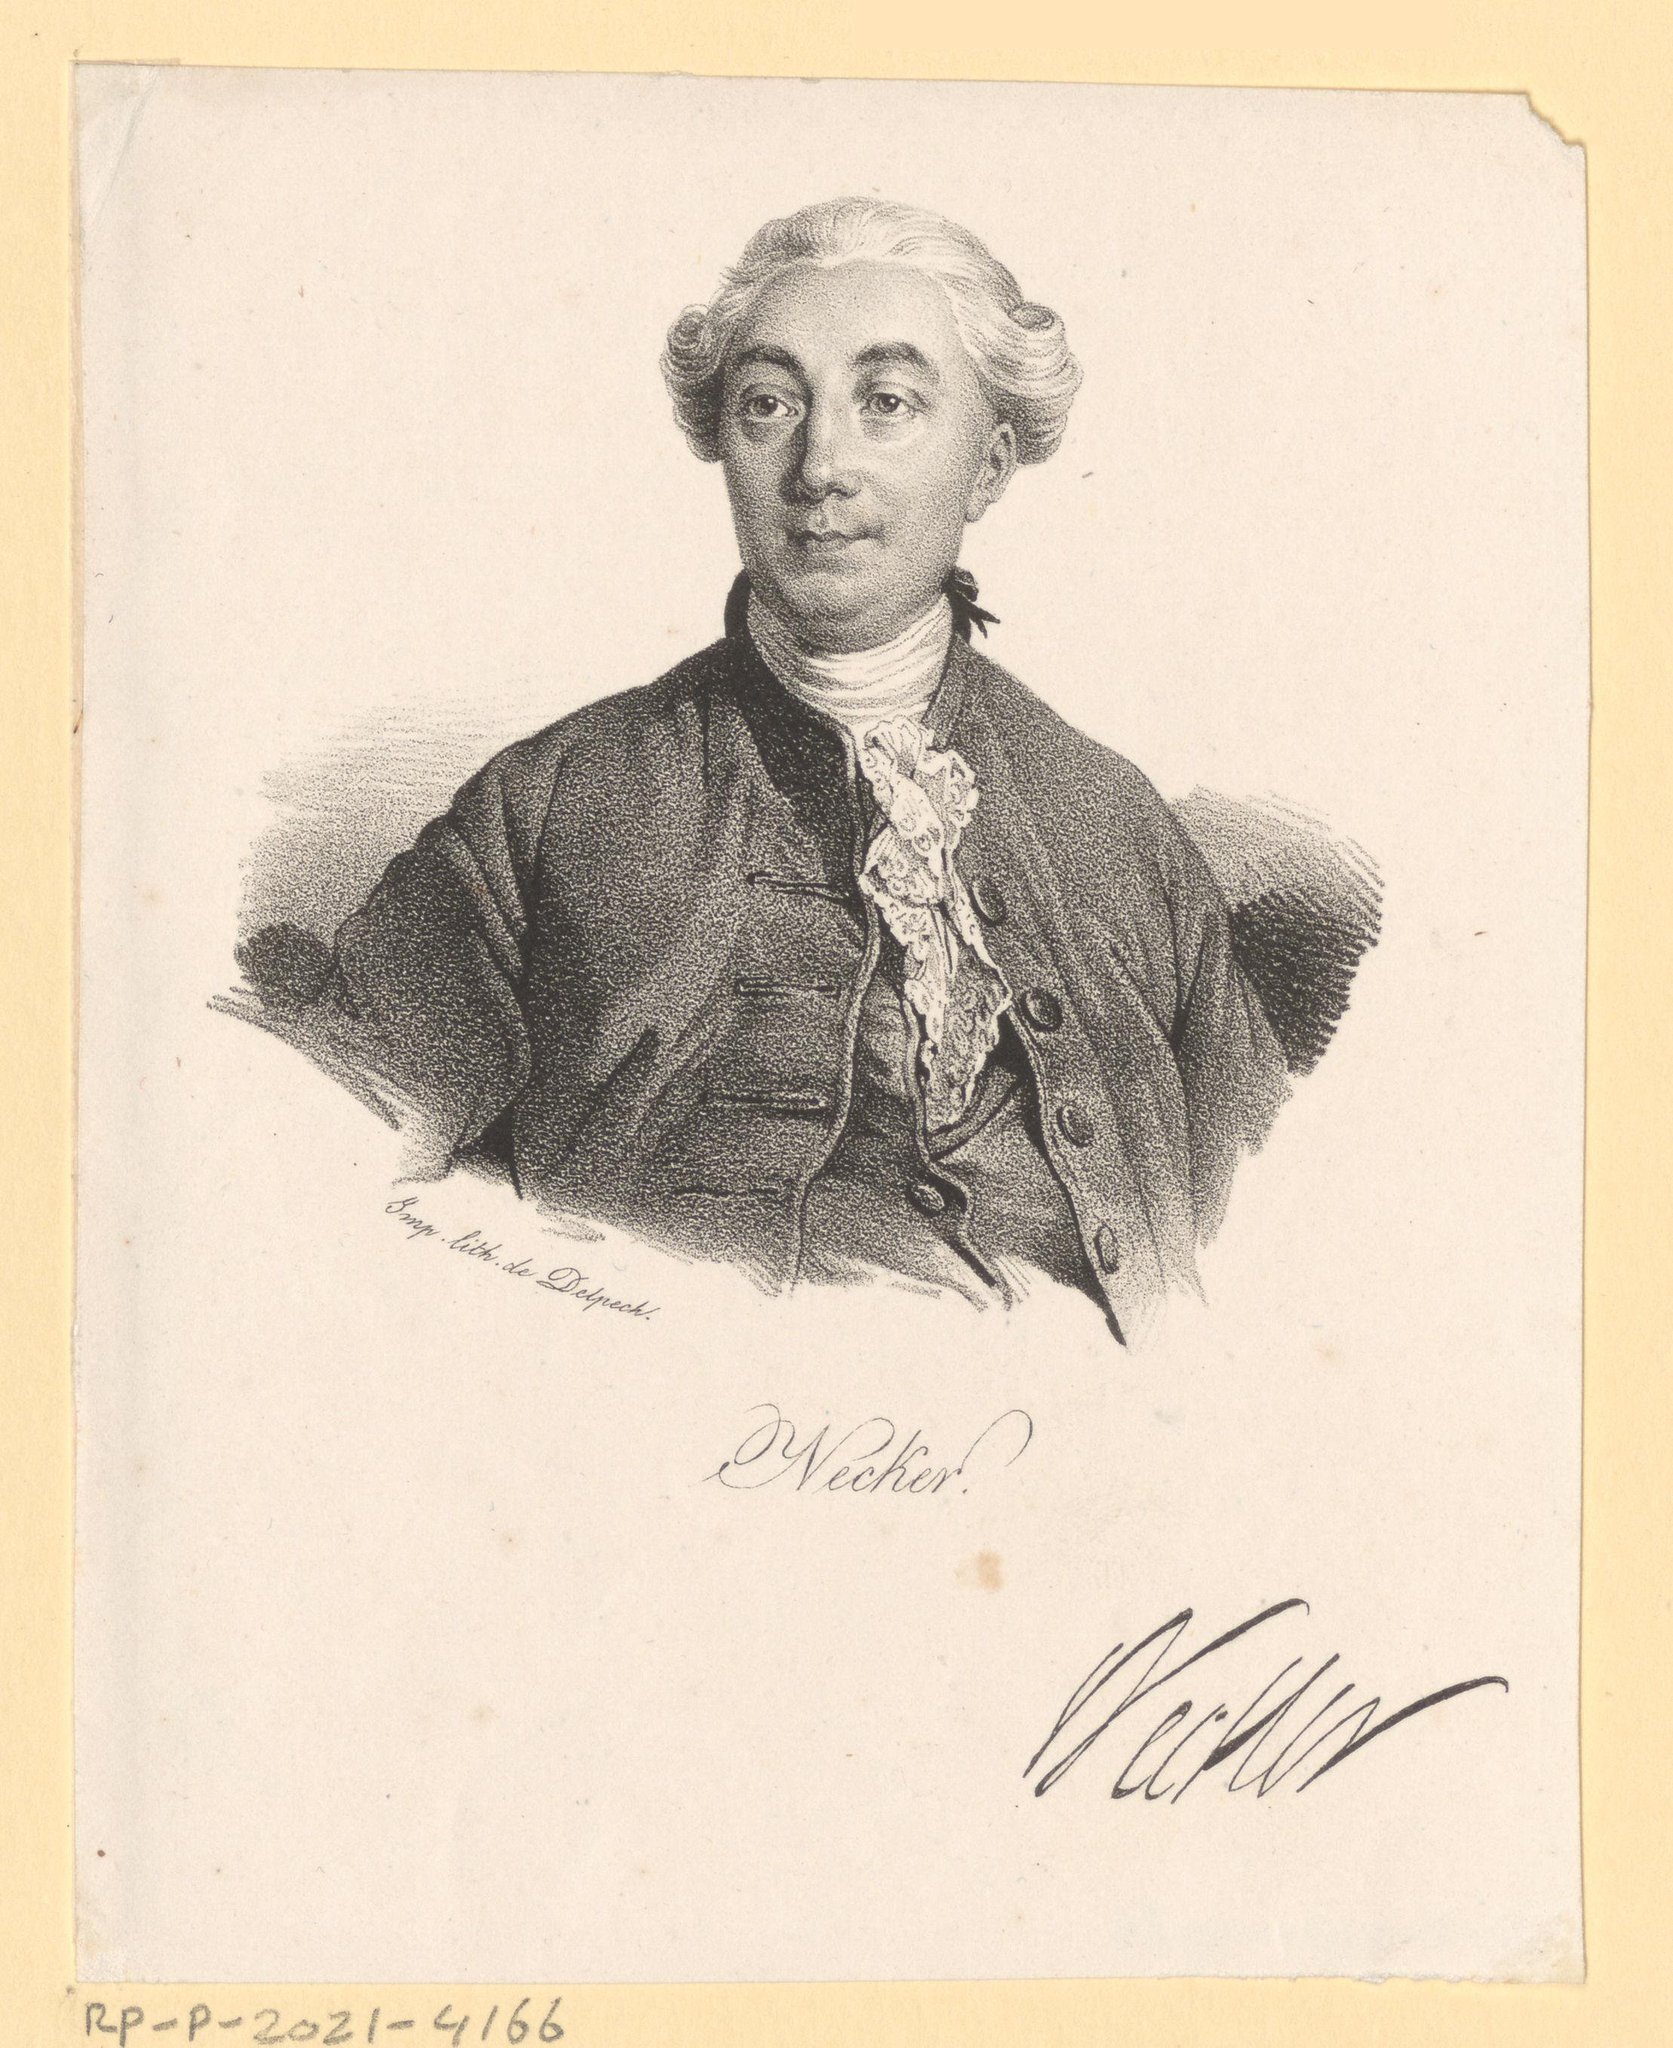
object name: print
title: Portret van Jacques Necker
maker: Anonymous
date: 1818-1842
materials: paper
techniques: lithograph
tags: minister ~ government, historical persons